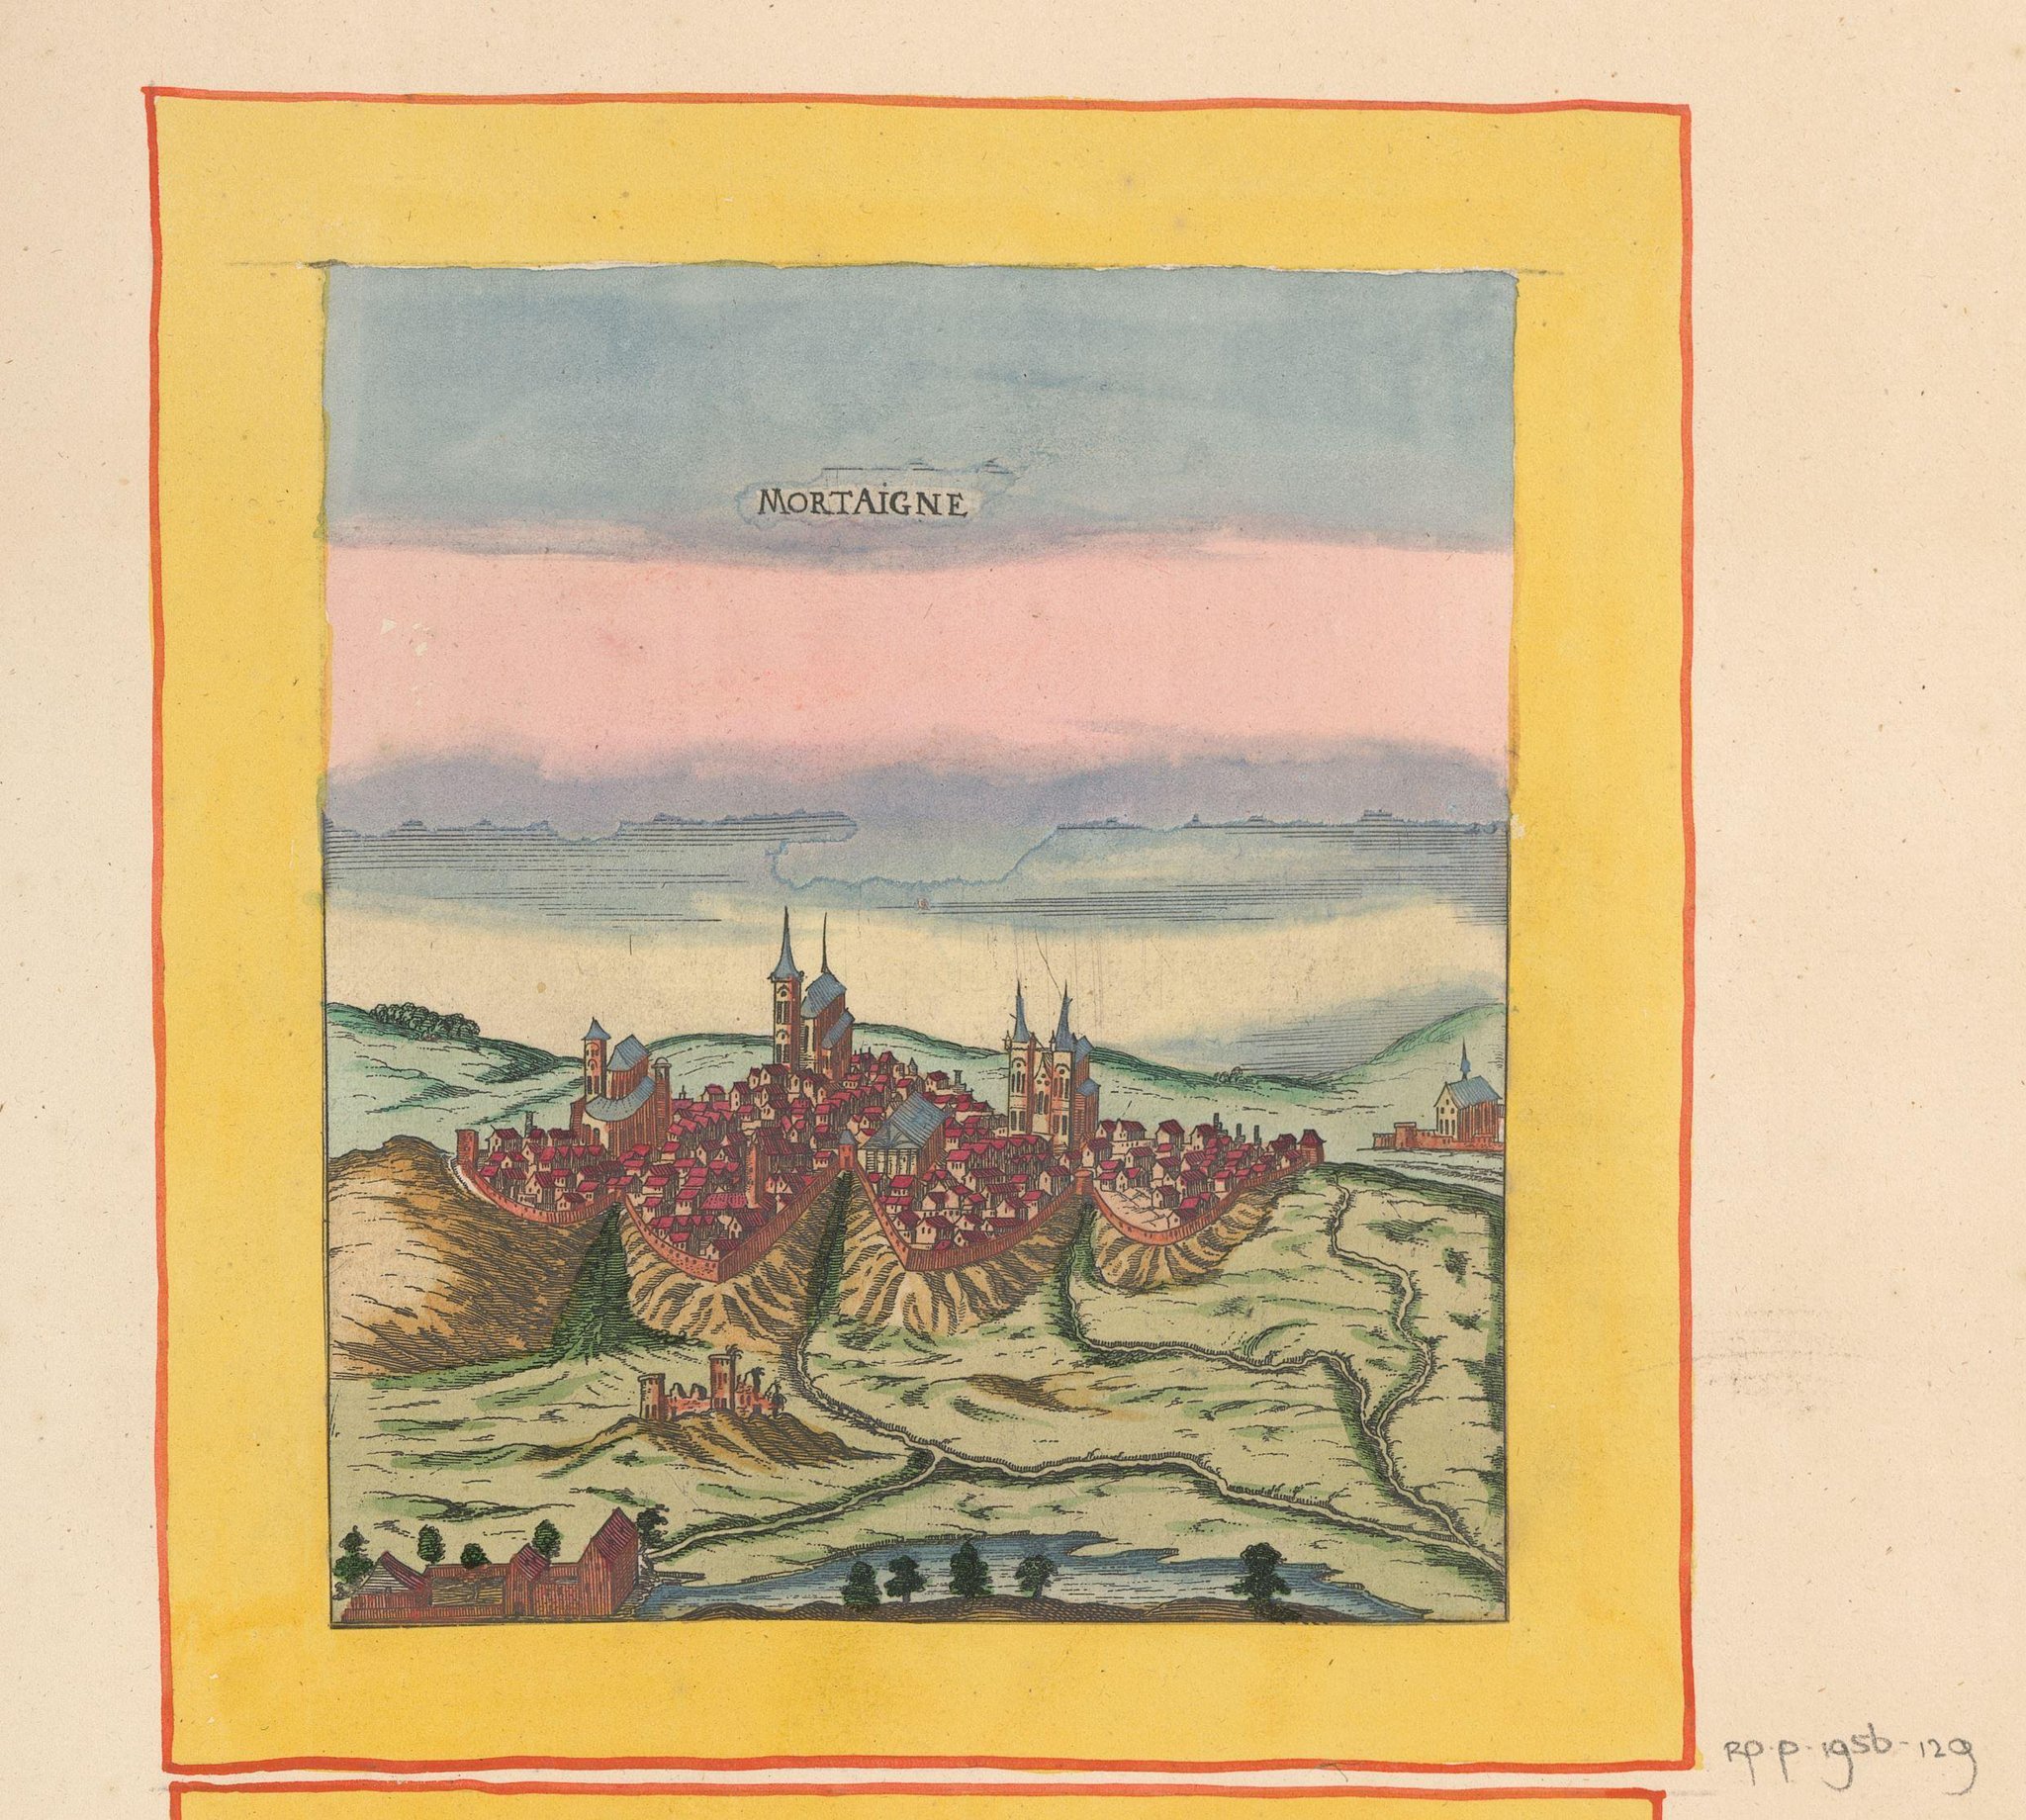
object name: album leaf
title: Mortaigne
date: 1638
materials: paper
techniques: engraving, etching, hand coloring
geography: paris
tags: city-view in general; 'veduta'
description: Prent uit: Tassin, Christophe. Les plans et profils de toutes les principales villes et lieux considérables de France (...). Parijs: Michel van Lochom, 1638, prent 25.